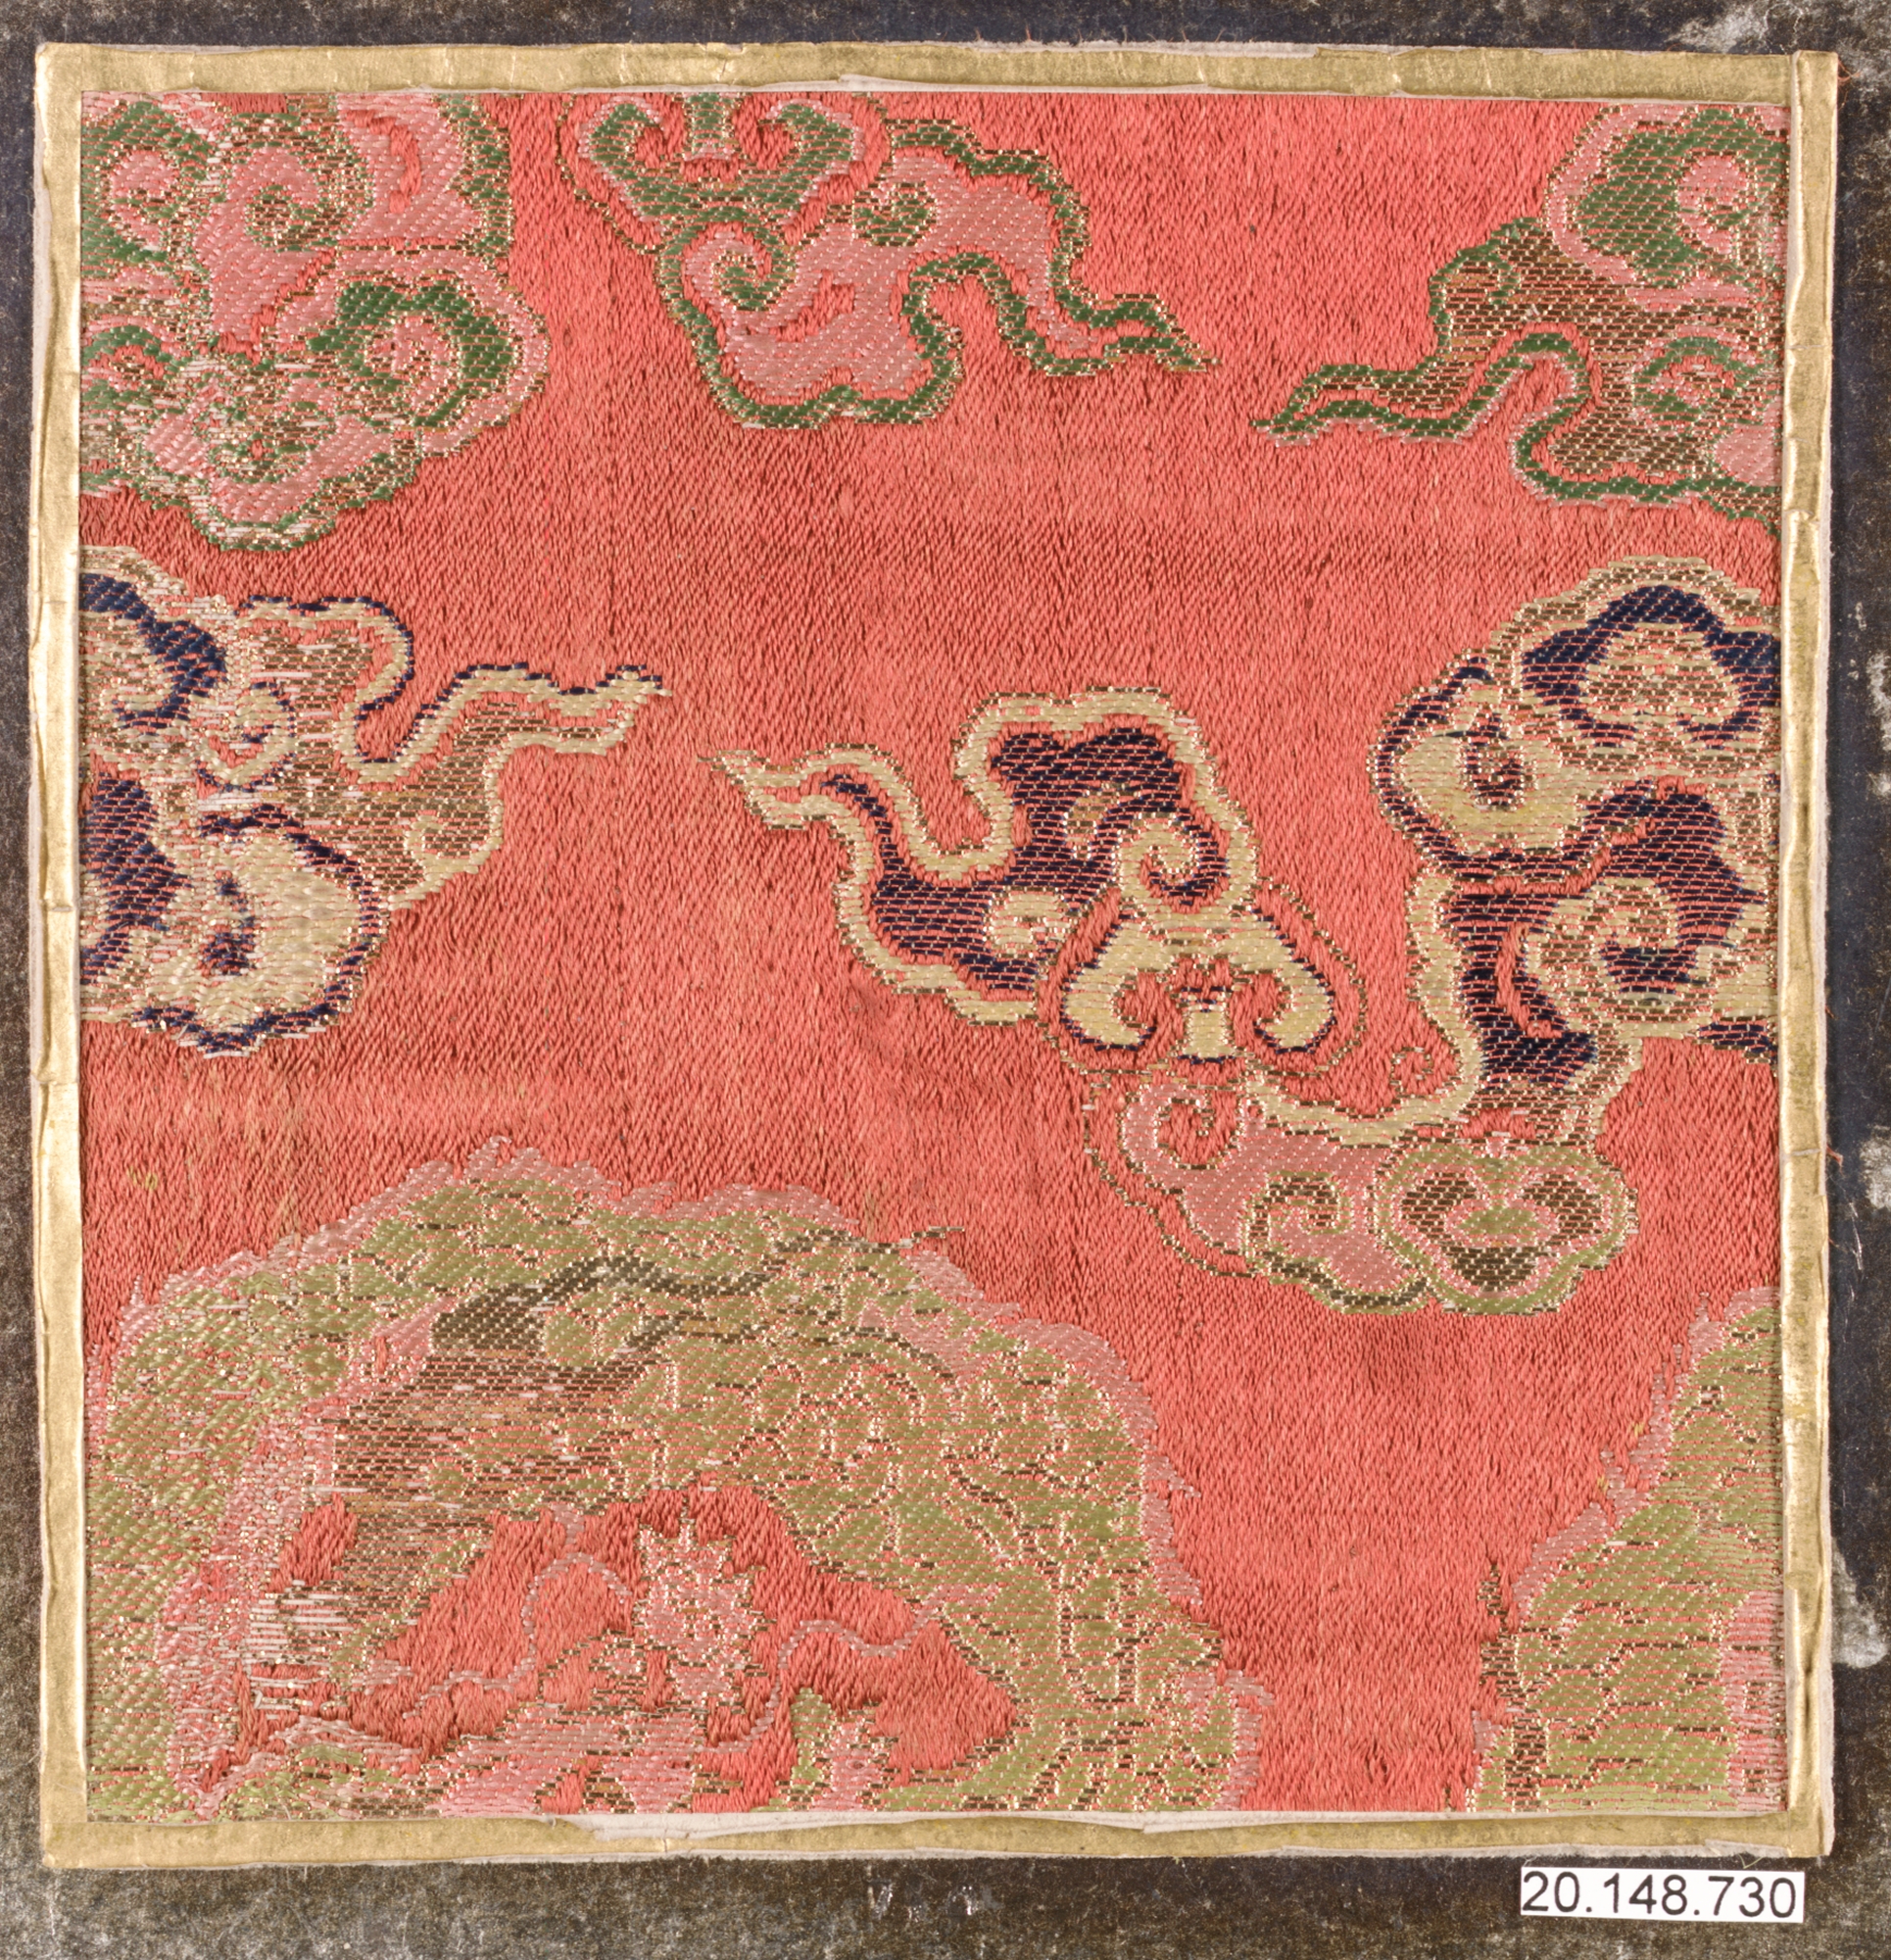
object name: piece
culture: japanese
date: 1701-1800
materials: silk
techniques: compound weave